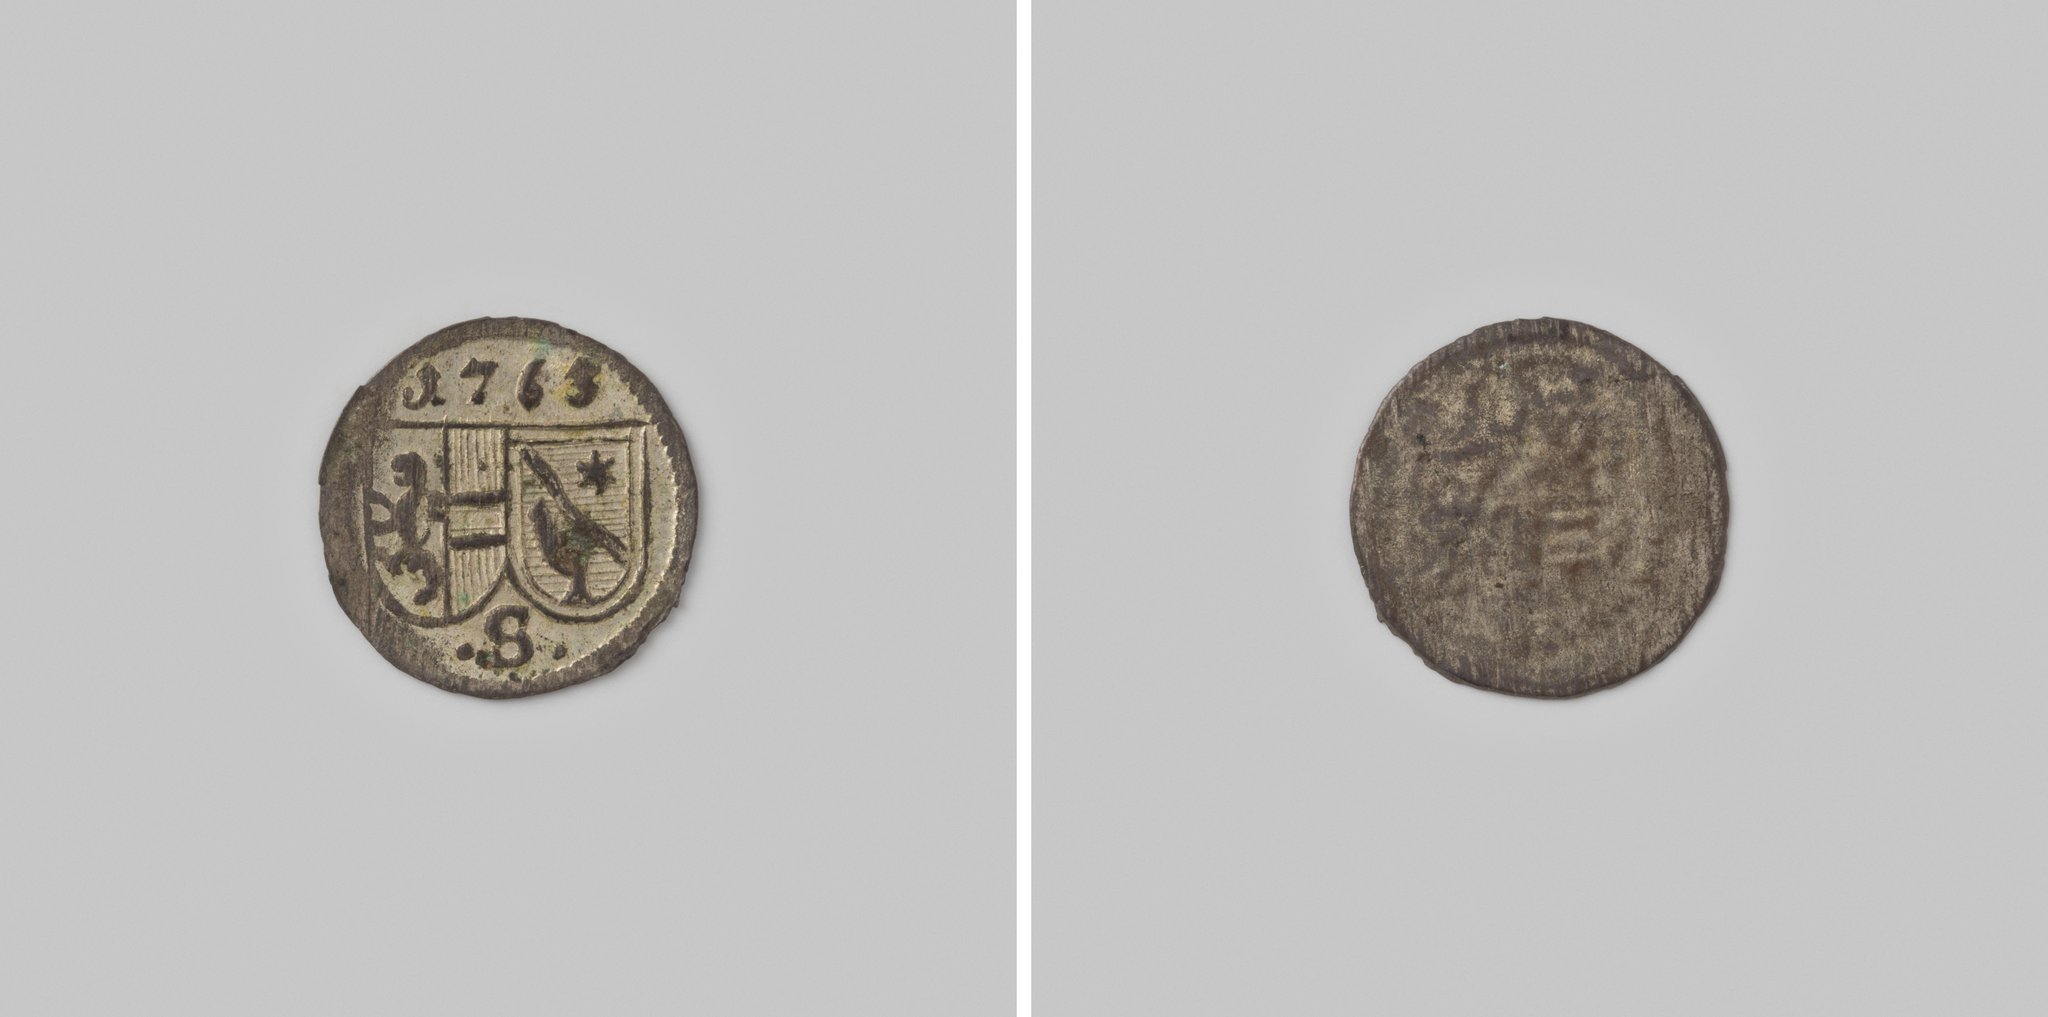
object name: coin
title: Aartsbisdom Salzburg, Sigismund III von Schrattenbach, pfenning,1765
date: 1765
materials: silver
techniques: striking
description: Zilveren enkelzijdige munt. Voorzijde: twee tegen elkaar geplaatste wapenschilden. Daarboven jaartal en daaronder de letter S [=Sigismund]. Keerzijde: glad.